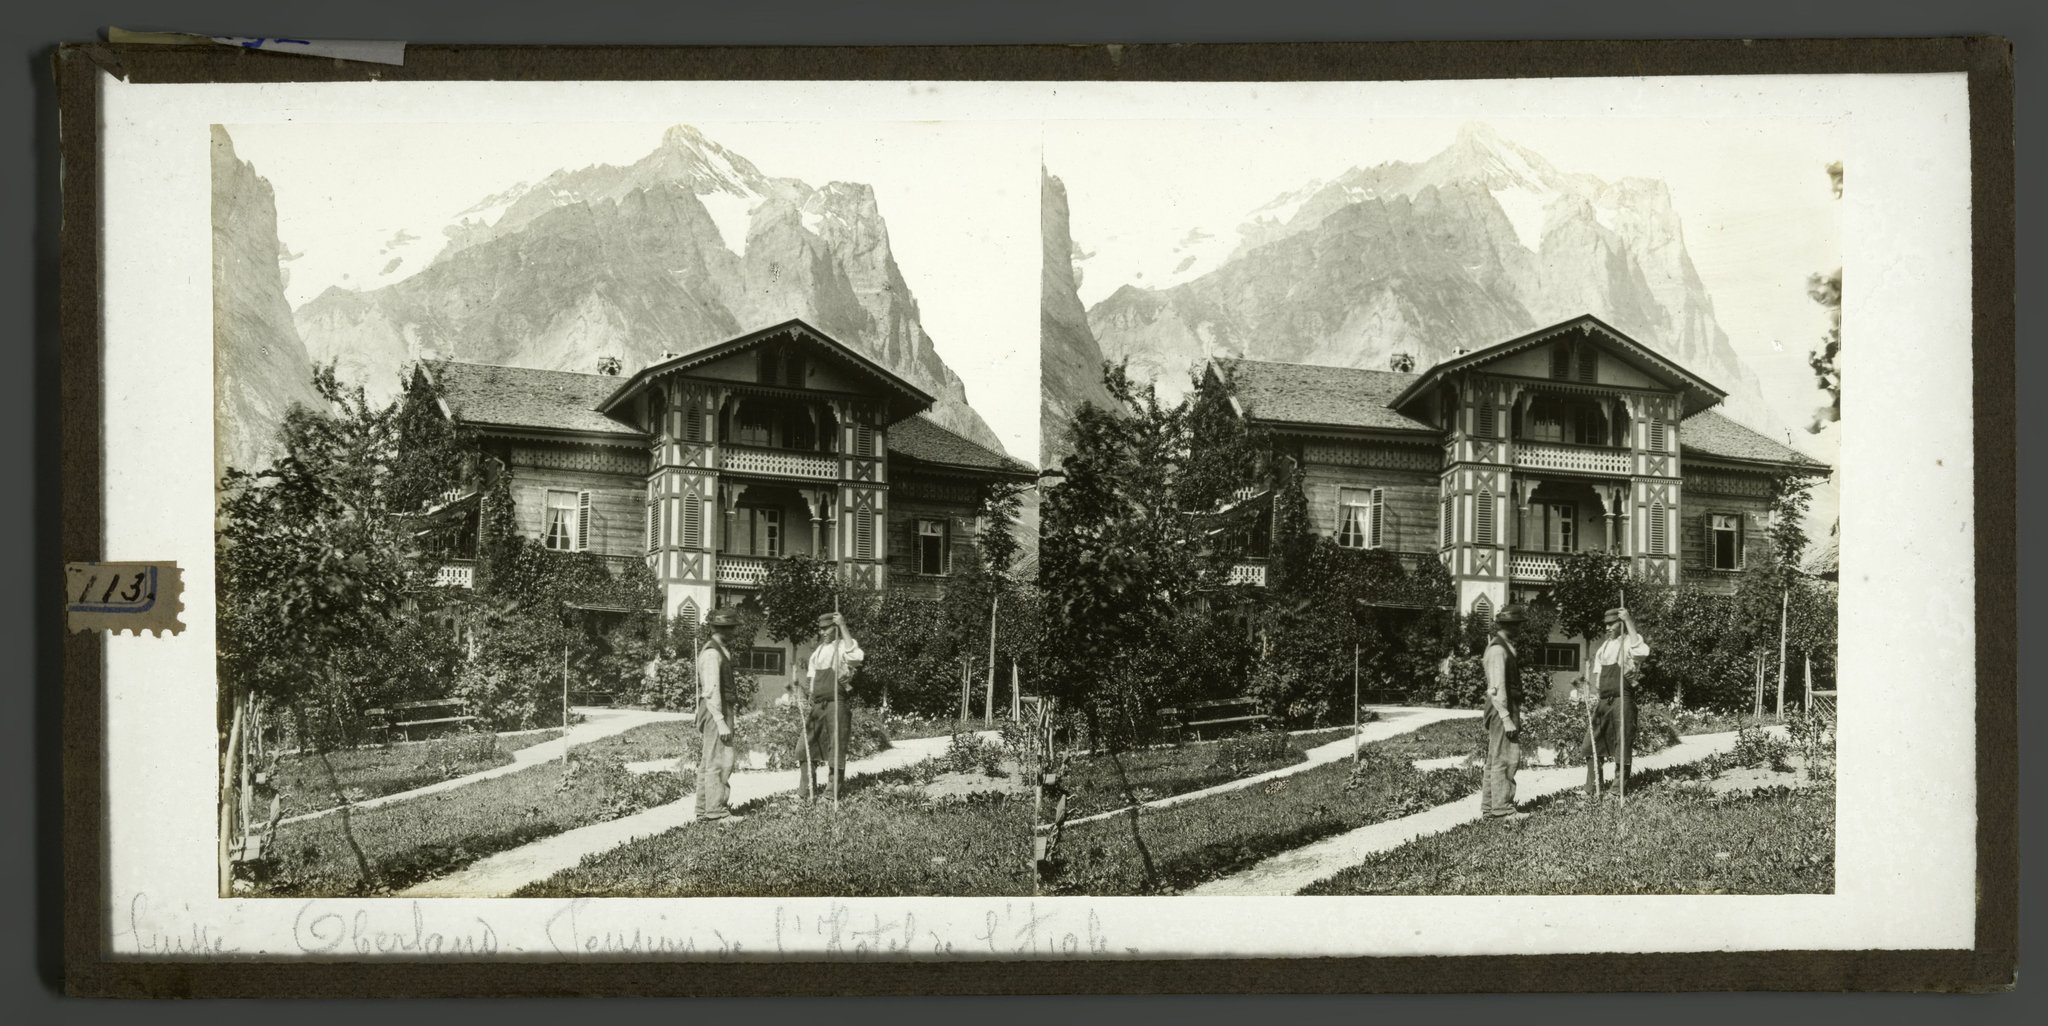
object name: stereoscopic photograph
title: Gezicht op een hotel in het Berner Oberland, Zwitserland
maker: Anonymous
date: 1856-1890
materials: glass, paper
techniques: slide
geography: berner oberland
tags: mountains (+ landscape with figures, staffage), hotel, hostelry, inn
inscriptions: number: ‘113.’, annotation: ‘Suisse. Oberland. Pension de l'Hôtel de l'Aiole.’